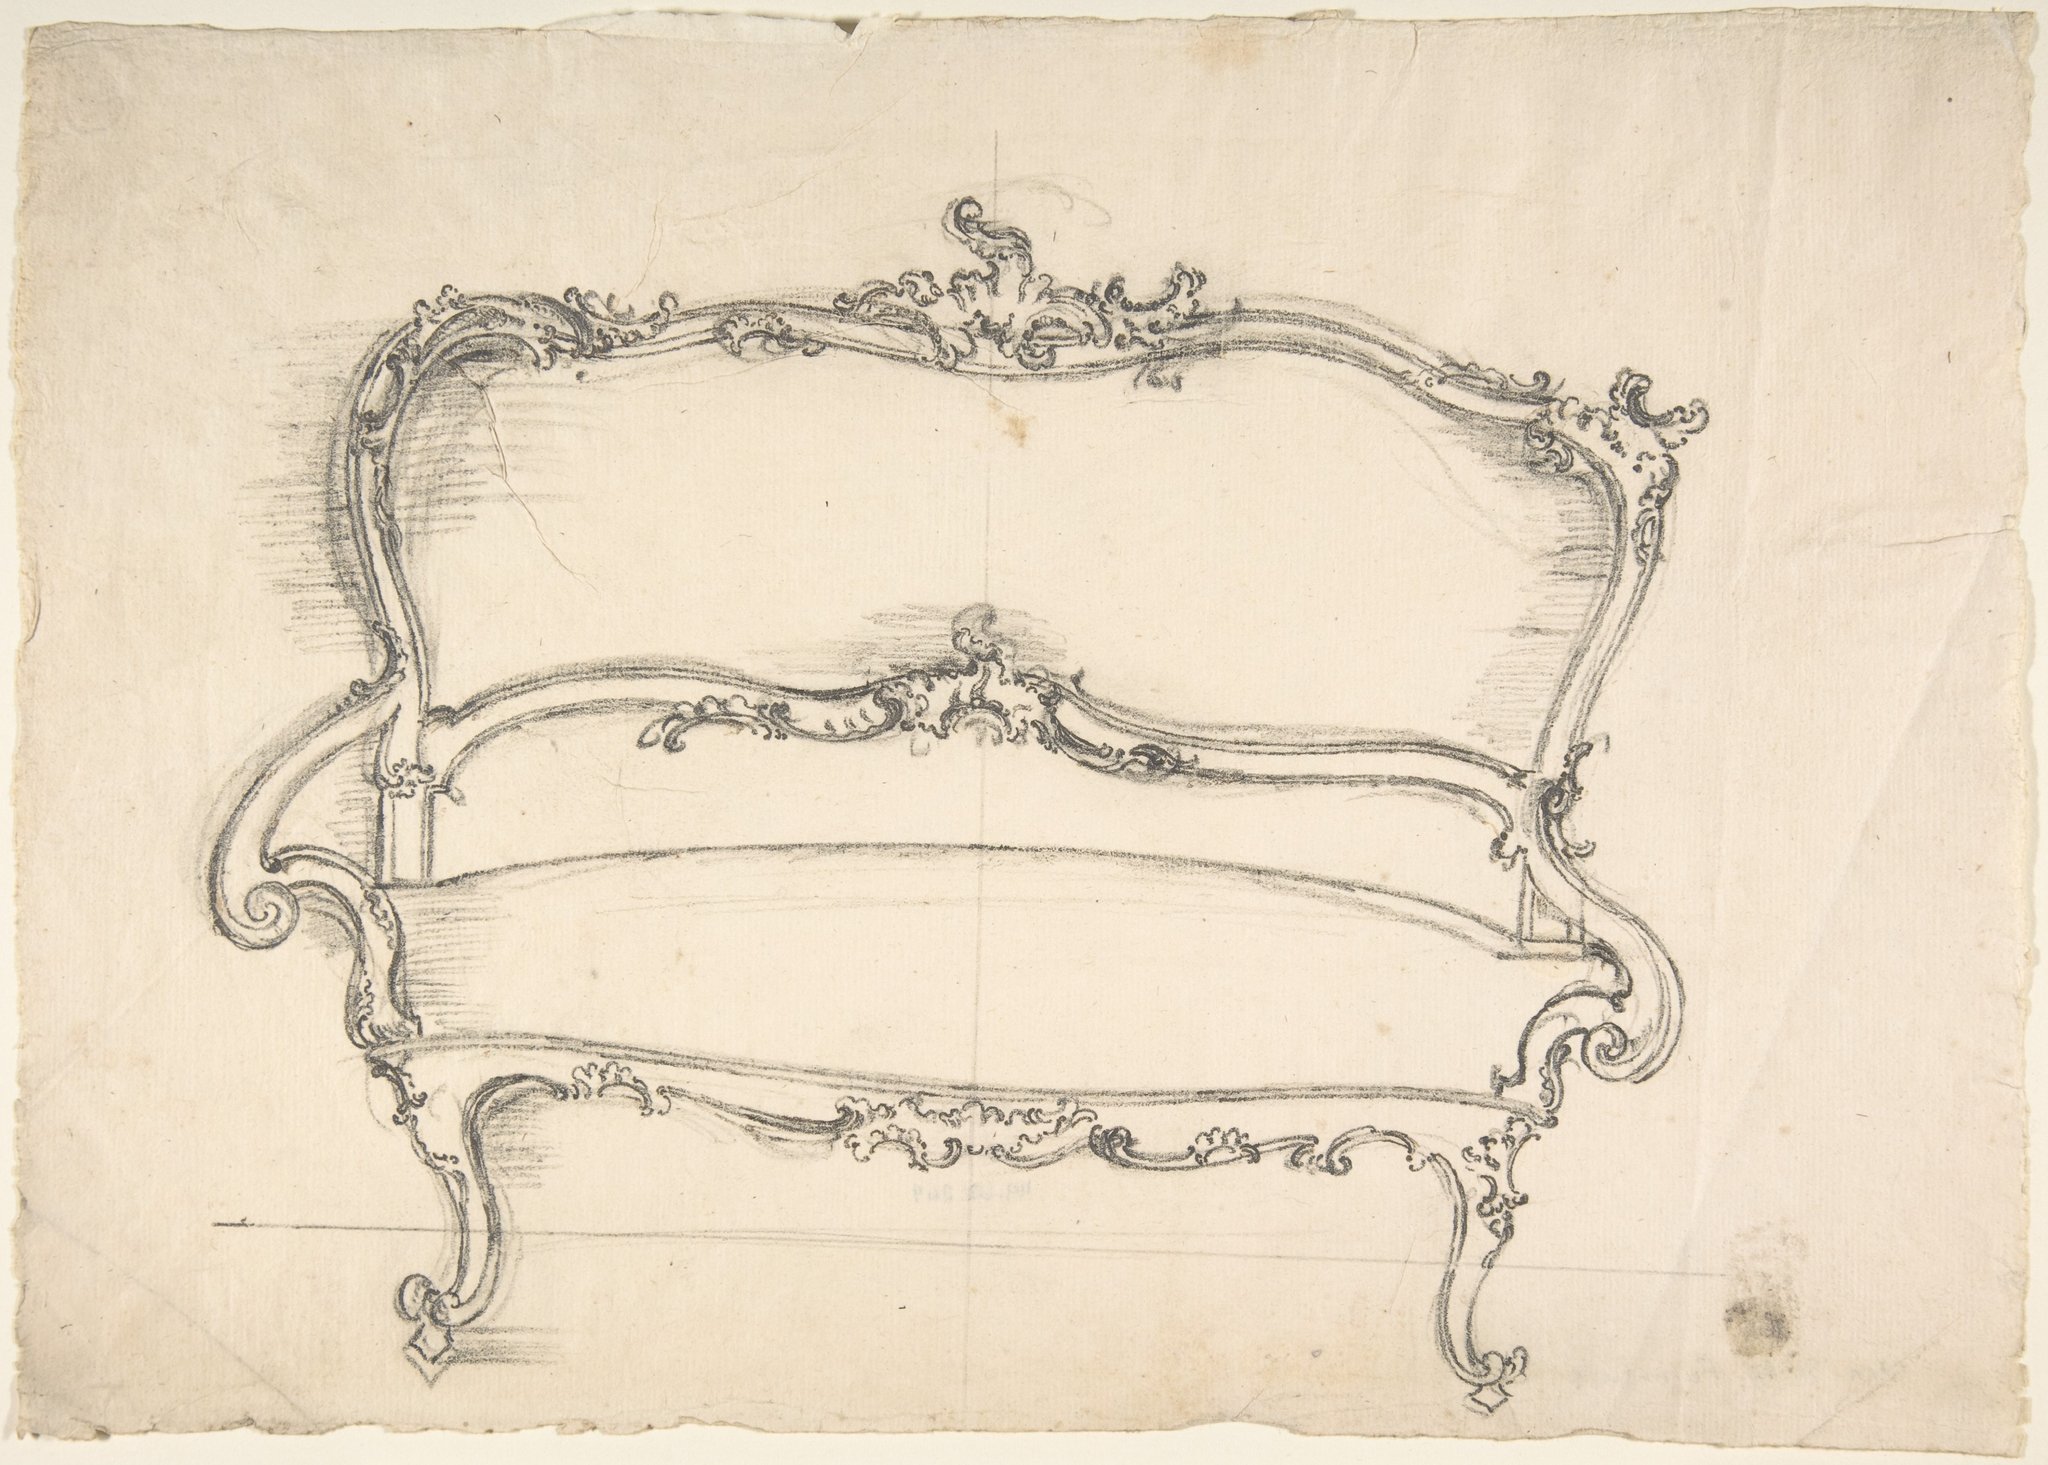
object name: drawing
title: Design for a Settee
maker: anonymous, german, 18th century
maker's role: artist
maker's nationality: german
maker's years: 1700-1800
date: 1701-1800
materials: graphite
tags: couches